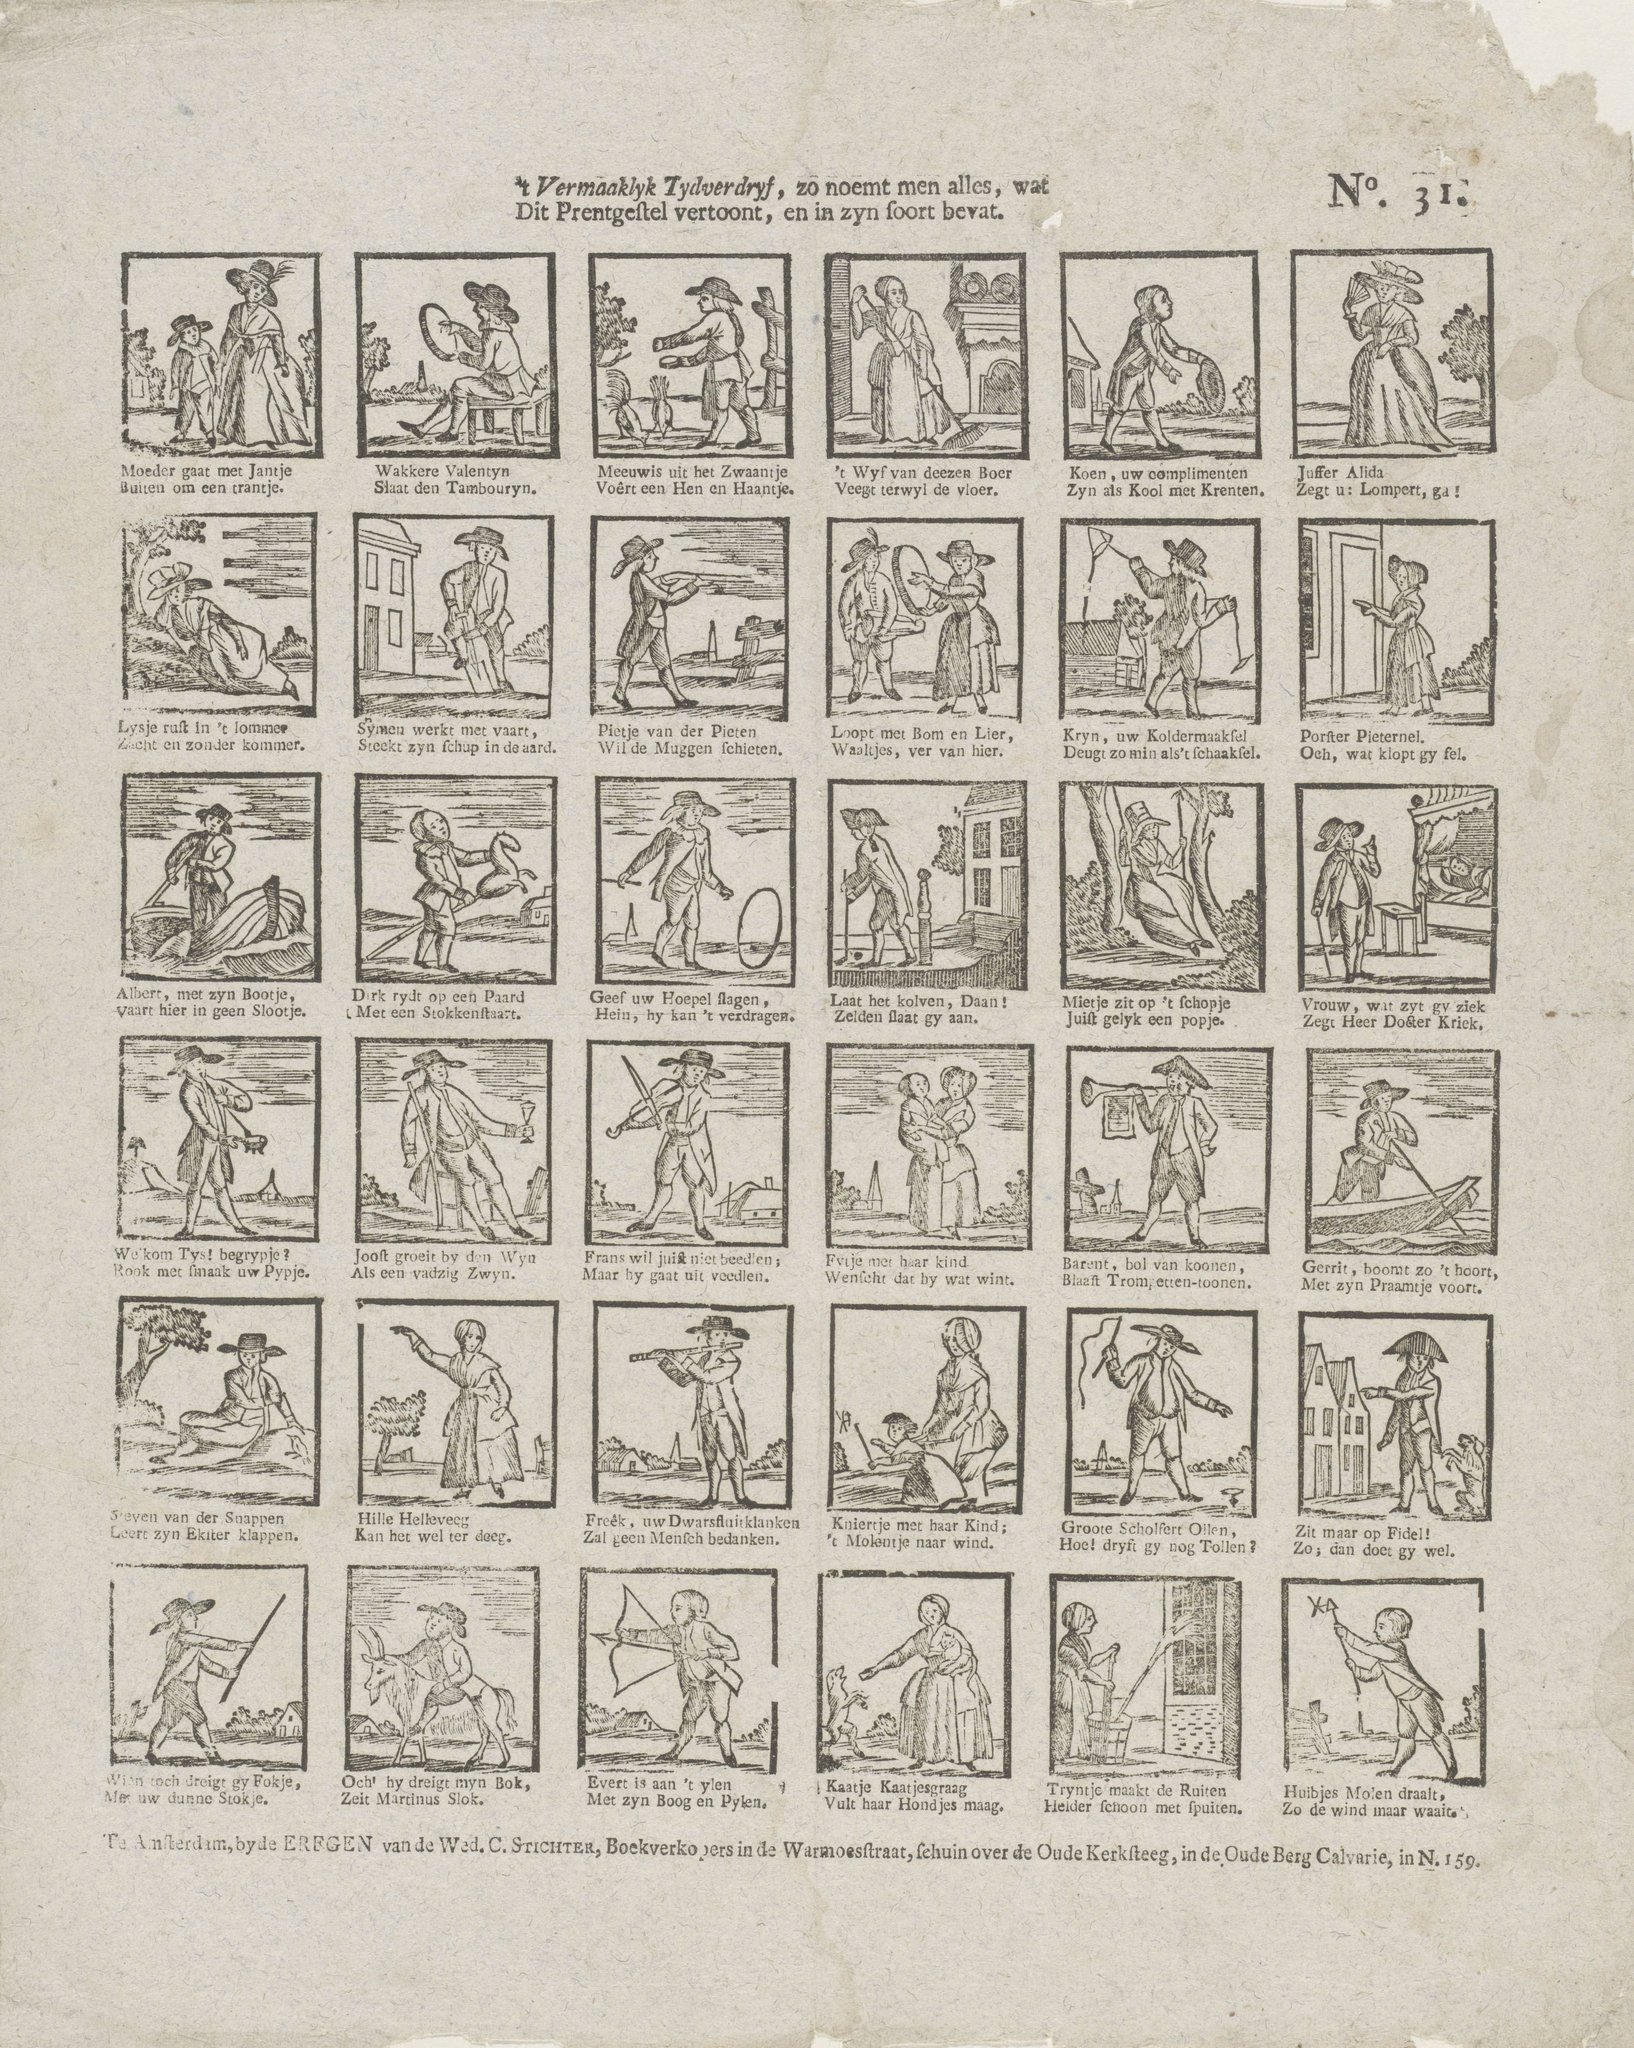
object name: print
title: 'T vermaaklyk tydverdryf, zo noemt men alles, wat / Dit prentgestel vertoont, en in zyn soort bevat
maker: Anonymous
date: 1715-1813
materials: paper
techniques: letterpress printing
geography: amsterdam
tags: recreation, amusement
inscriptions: collector's mark: Lugt 2760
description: Blad met 36 voorstellingen van tijdverdrijf, kinderspelen en vormen van recreatie. Onder elke afbeelding een tweeregelig vers. Genummerd rechtsboven: No. 31.